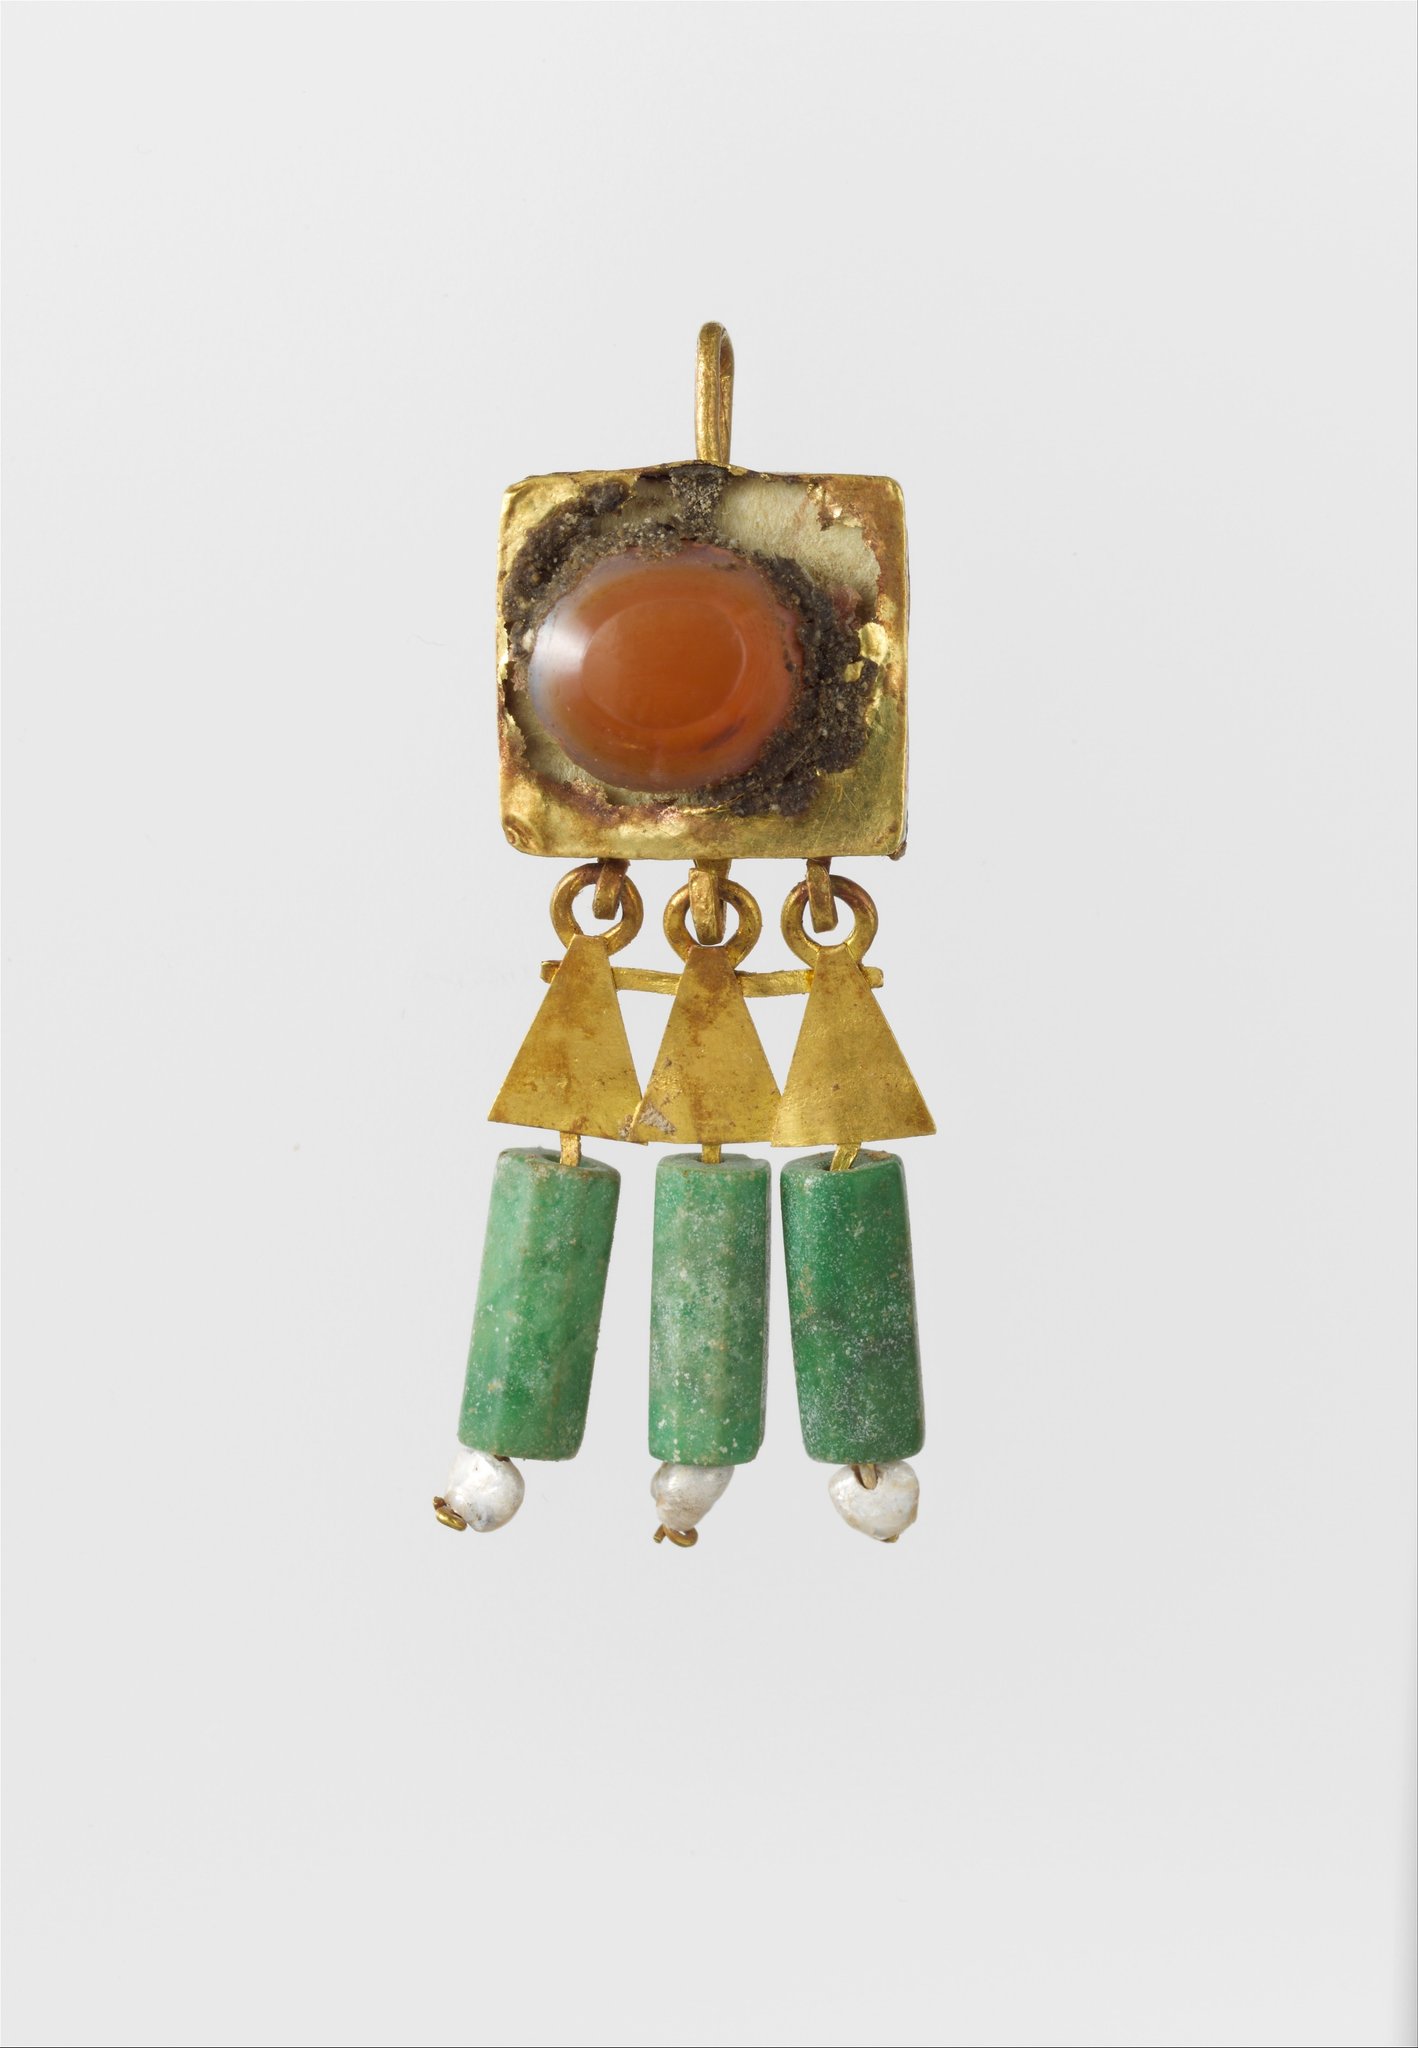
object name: earring hook type, with pendant and agate setting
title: Earring-hook type, with pendants and agate setting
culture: roman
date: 201-300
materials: stone, gold